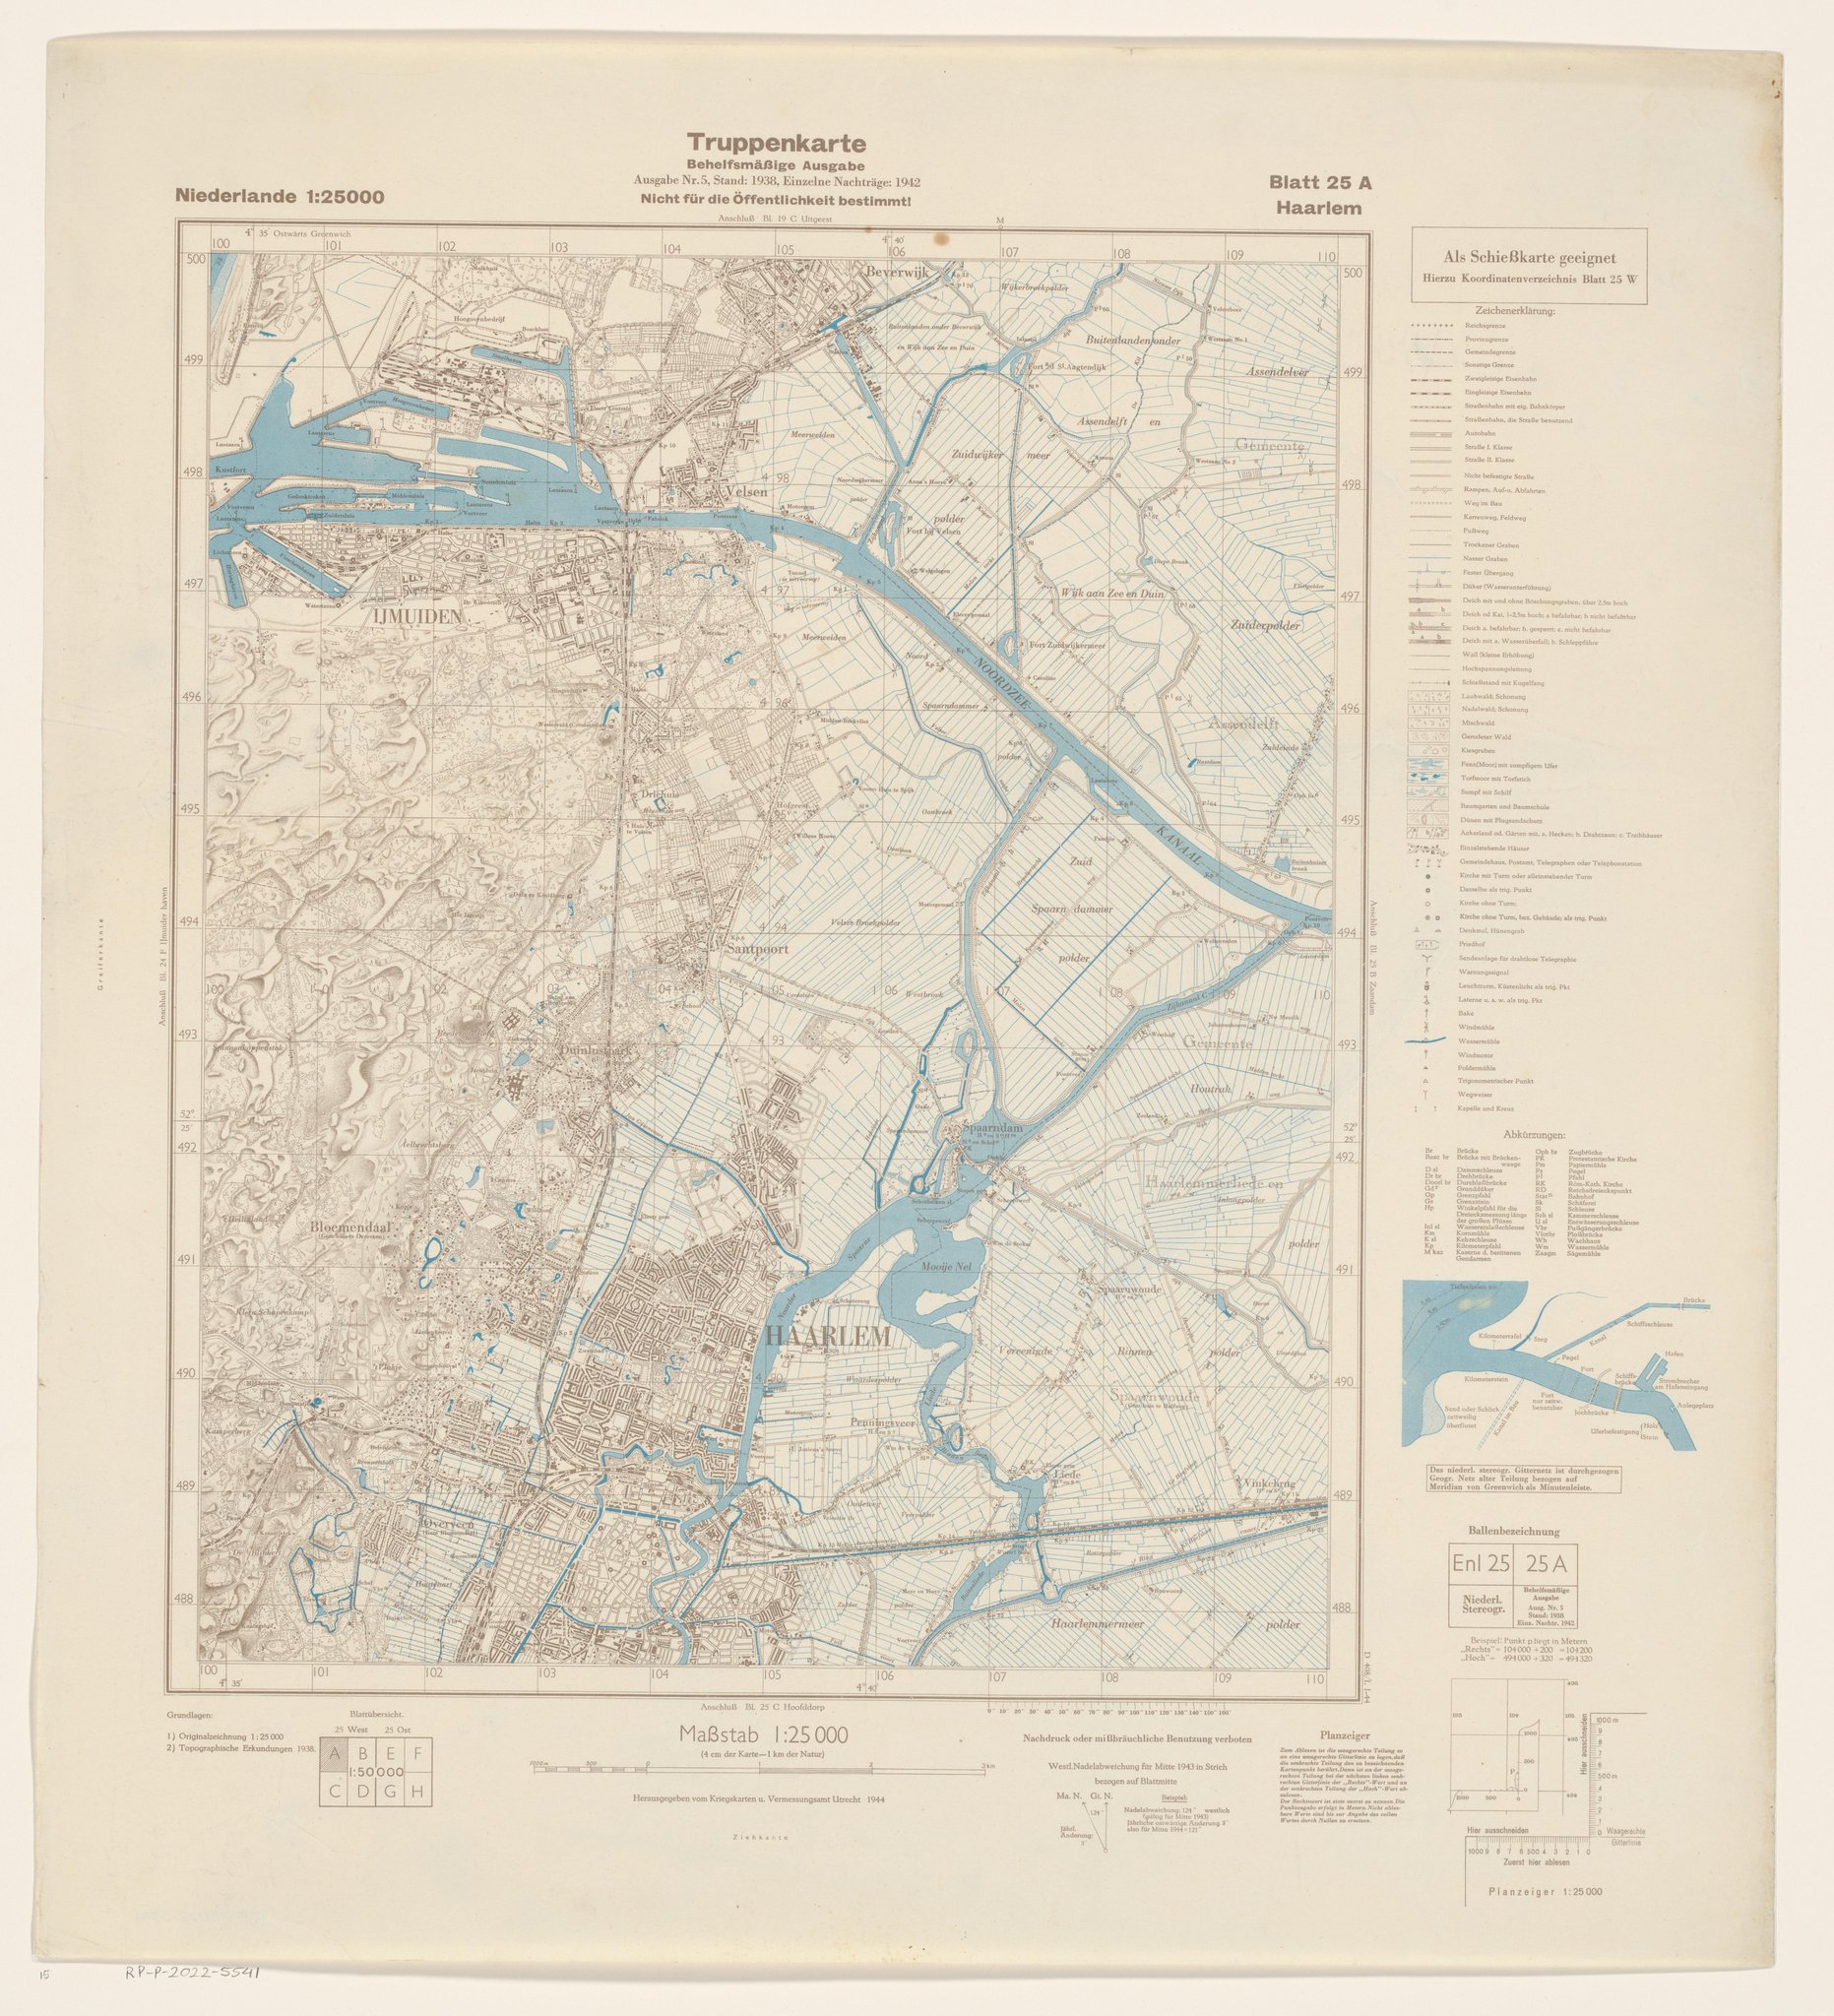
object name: map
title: Truppenkarte / Blatt 25A Haarlem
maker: Anonymous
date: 1944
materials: paper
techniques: lithograph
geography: netherlands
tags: maps of separate countries or regions, haarlem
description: Duitse militaire kaart van het gebied tussen Haarlem en IJmuiden, met deel van het Noordzeekanaal. Aan de rechterzijde de legenda. Schaal 1 : 25000.